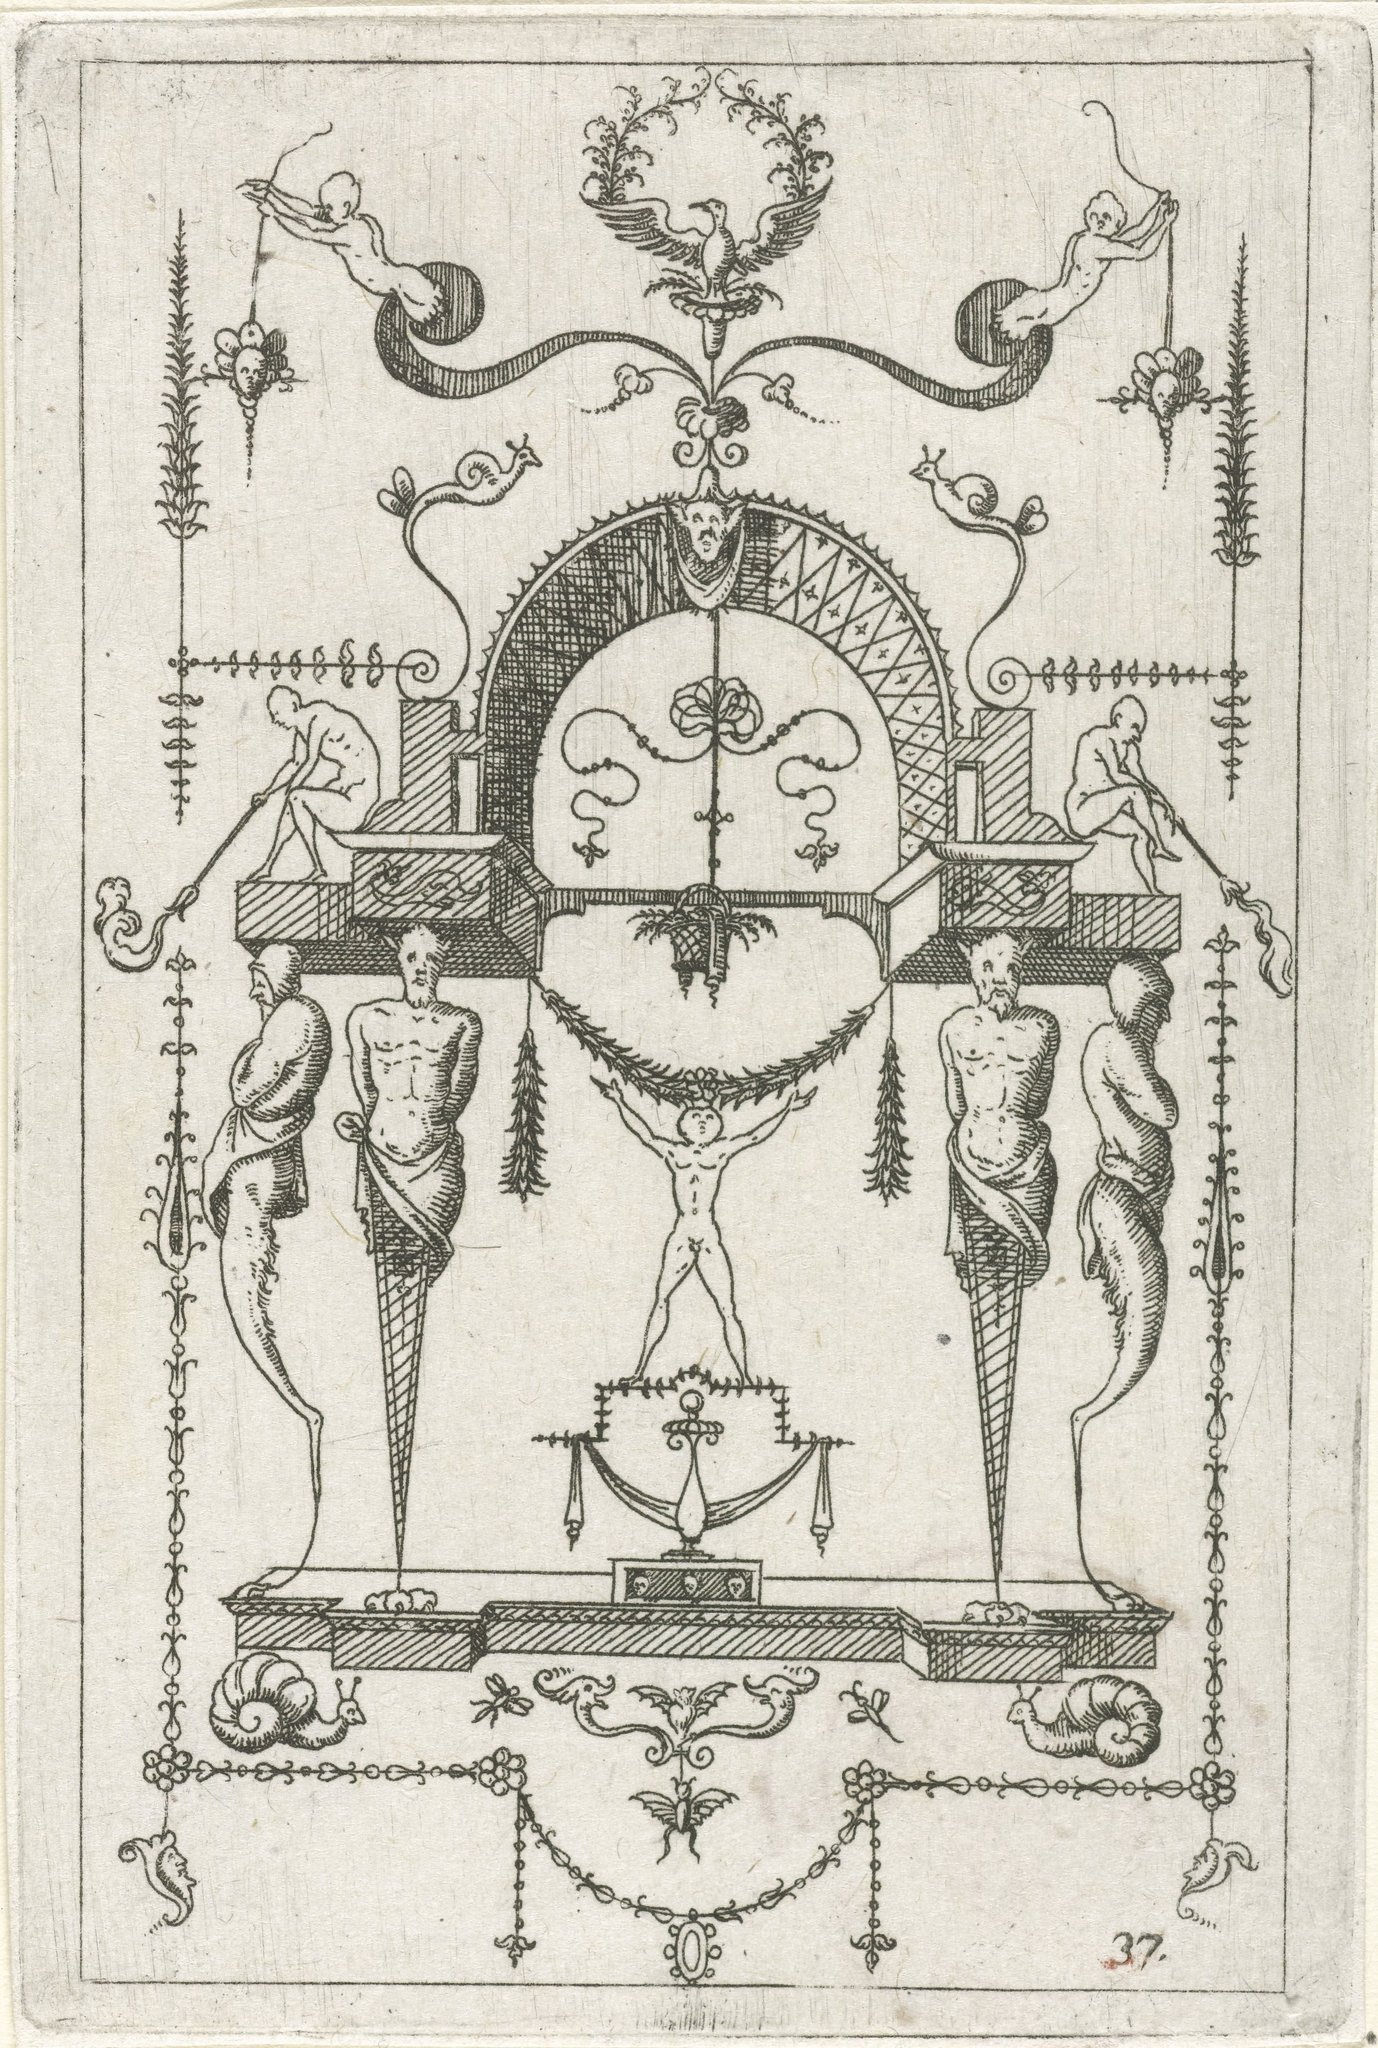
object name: print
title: Een met ruiten gedecoreerde boog gedragen door vier hermen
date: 1525-1594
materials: paper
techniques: etching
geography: france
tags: herm: pillar with the head of mercury, patron of travellers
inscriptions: collector's mark: Lugt 240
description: Kopie naar prent van Jacques Androuet Ducerceau, ontleend aan een vlakdecoratie van Enea Vico. Blad uit serie met architectuurfantasieën en grotesken met fabelwezens, guirlandes, kandelabers en mascarons.